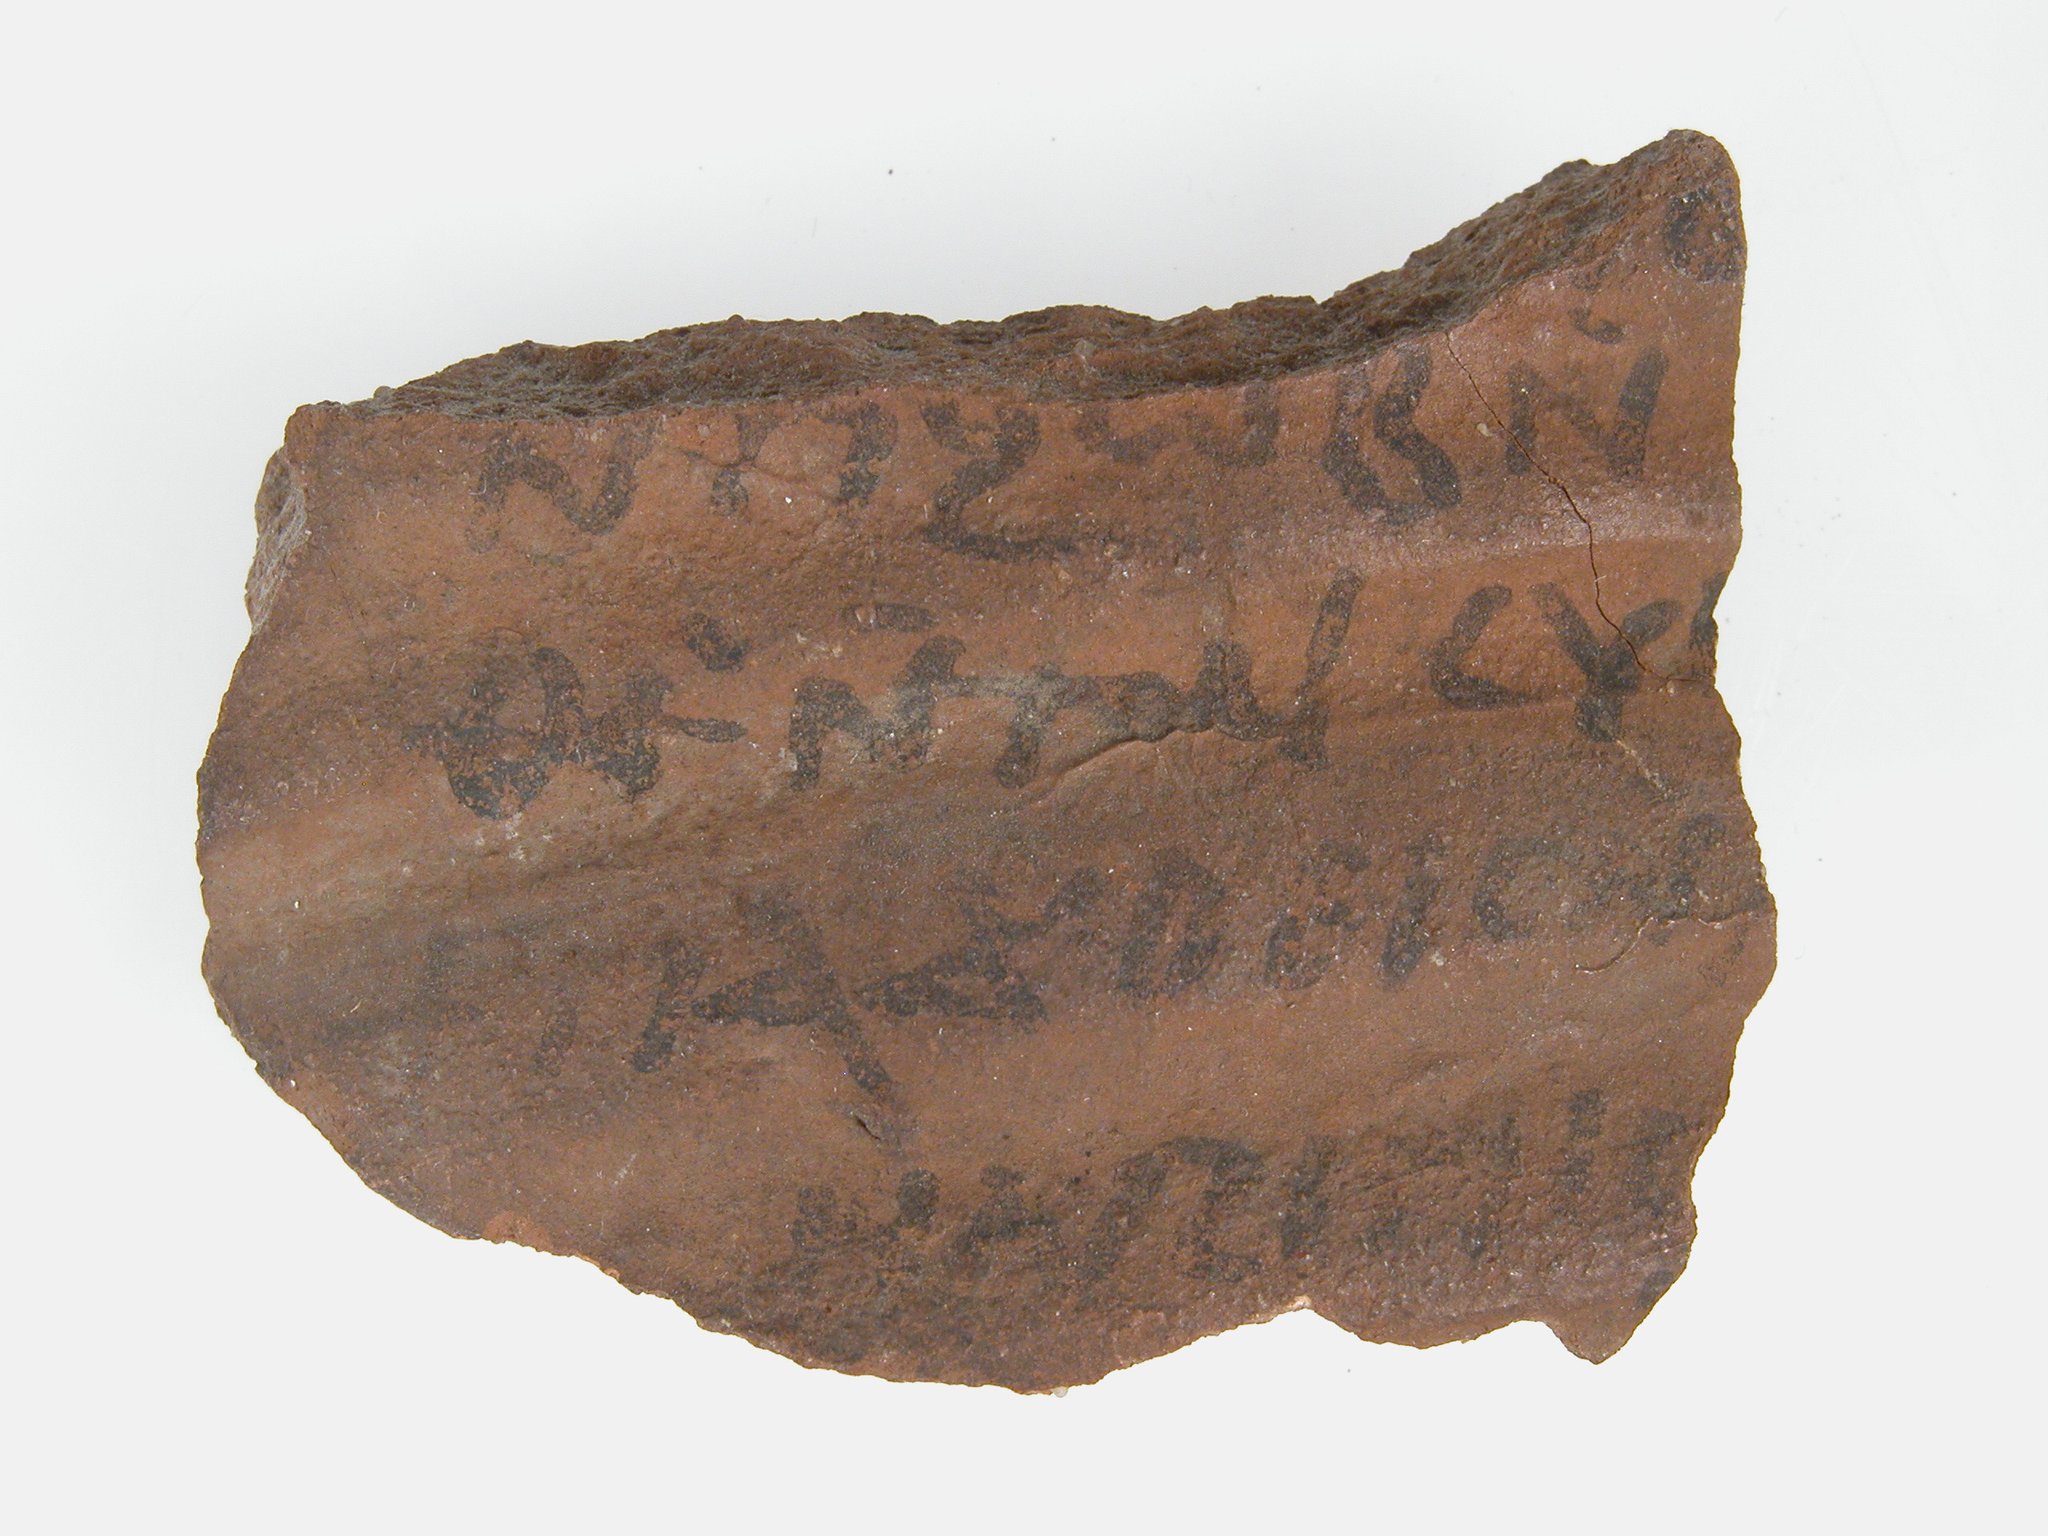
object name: ostrakon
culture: coptic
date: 580-640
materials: ink, pottery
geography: egypt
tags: coptic,documents